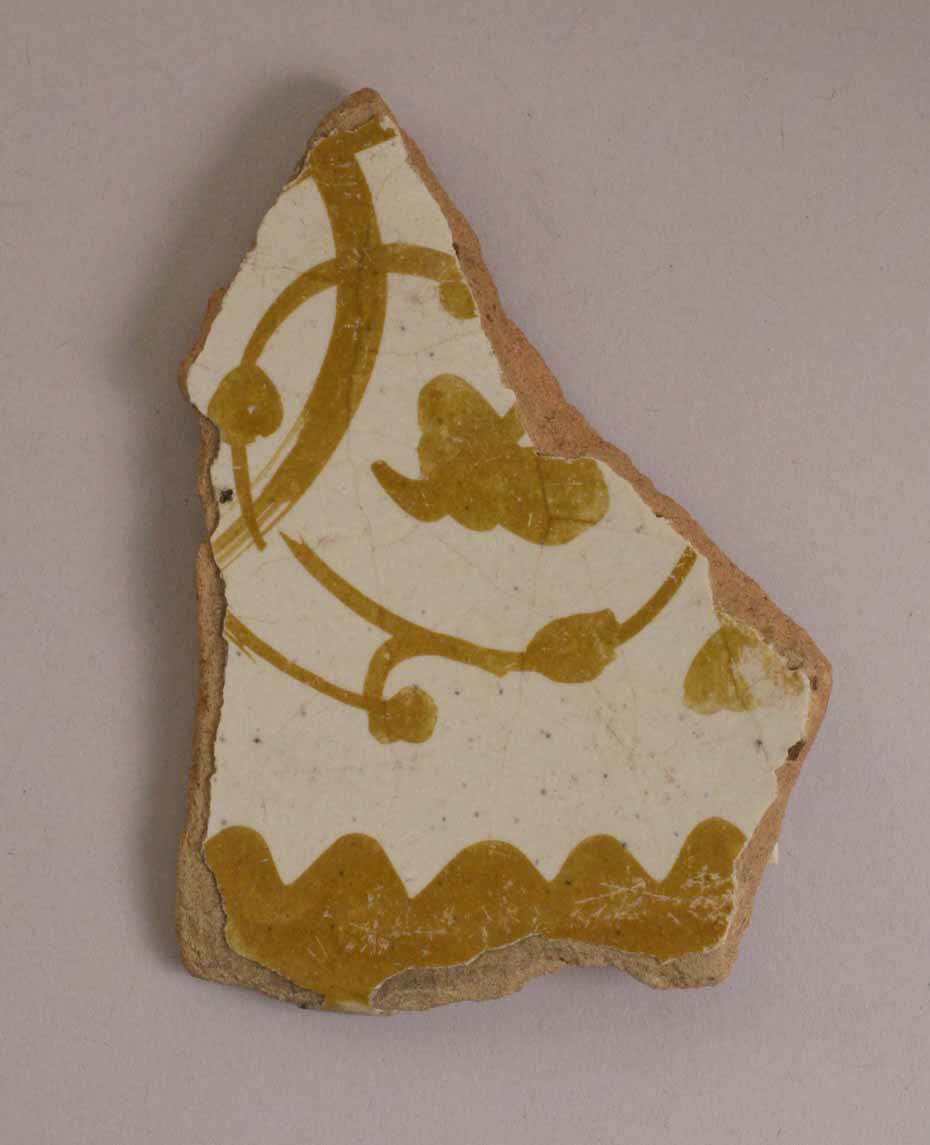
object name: ceramic fragment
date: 1001-1200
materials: earthenware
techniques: luster painting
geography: egypt